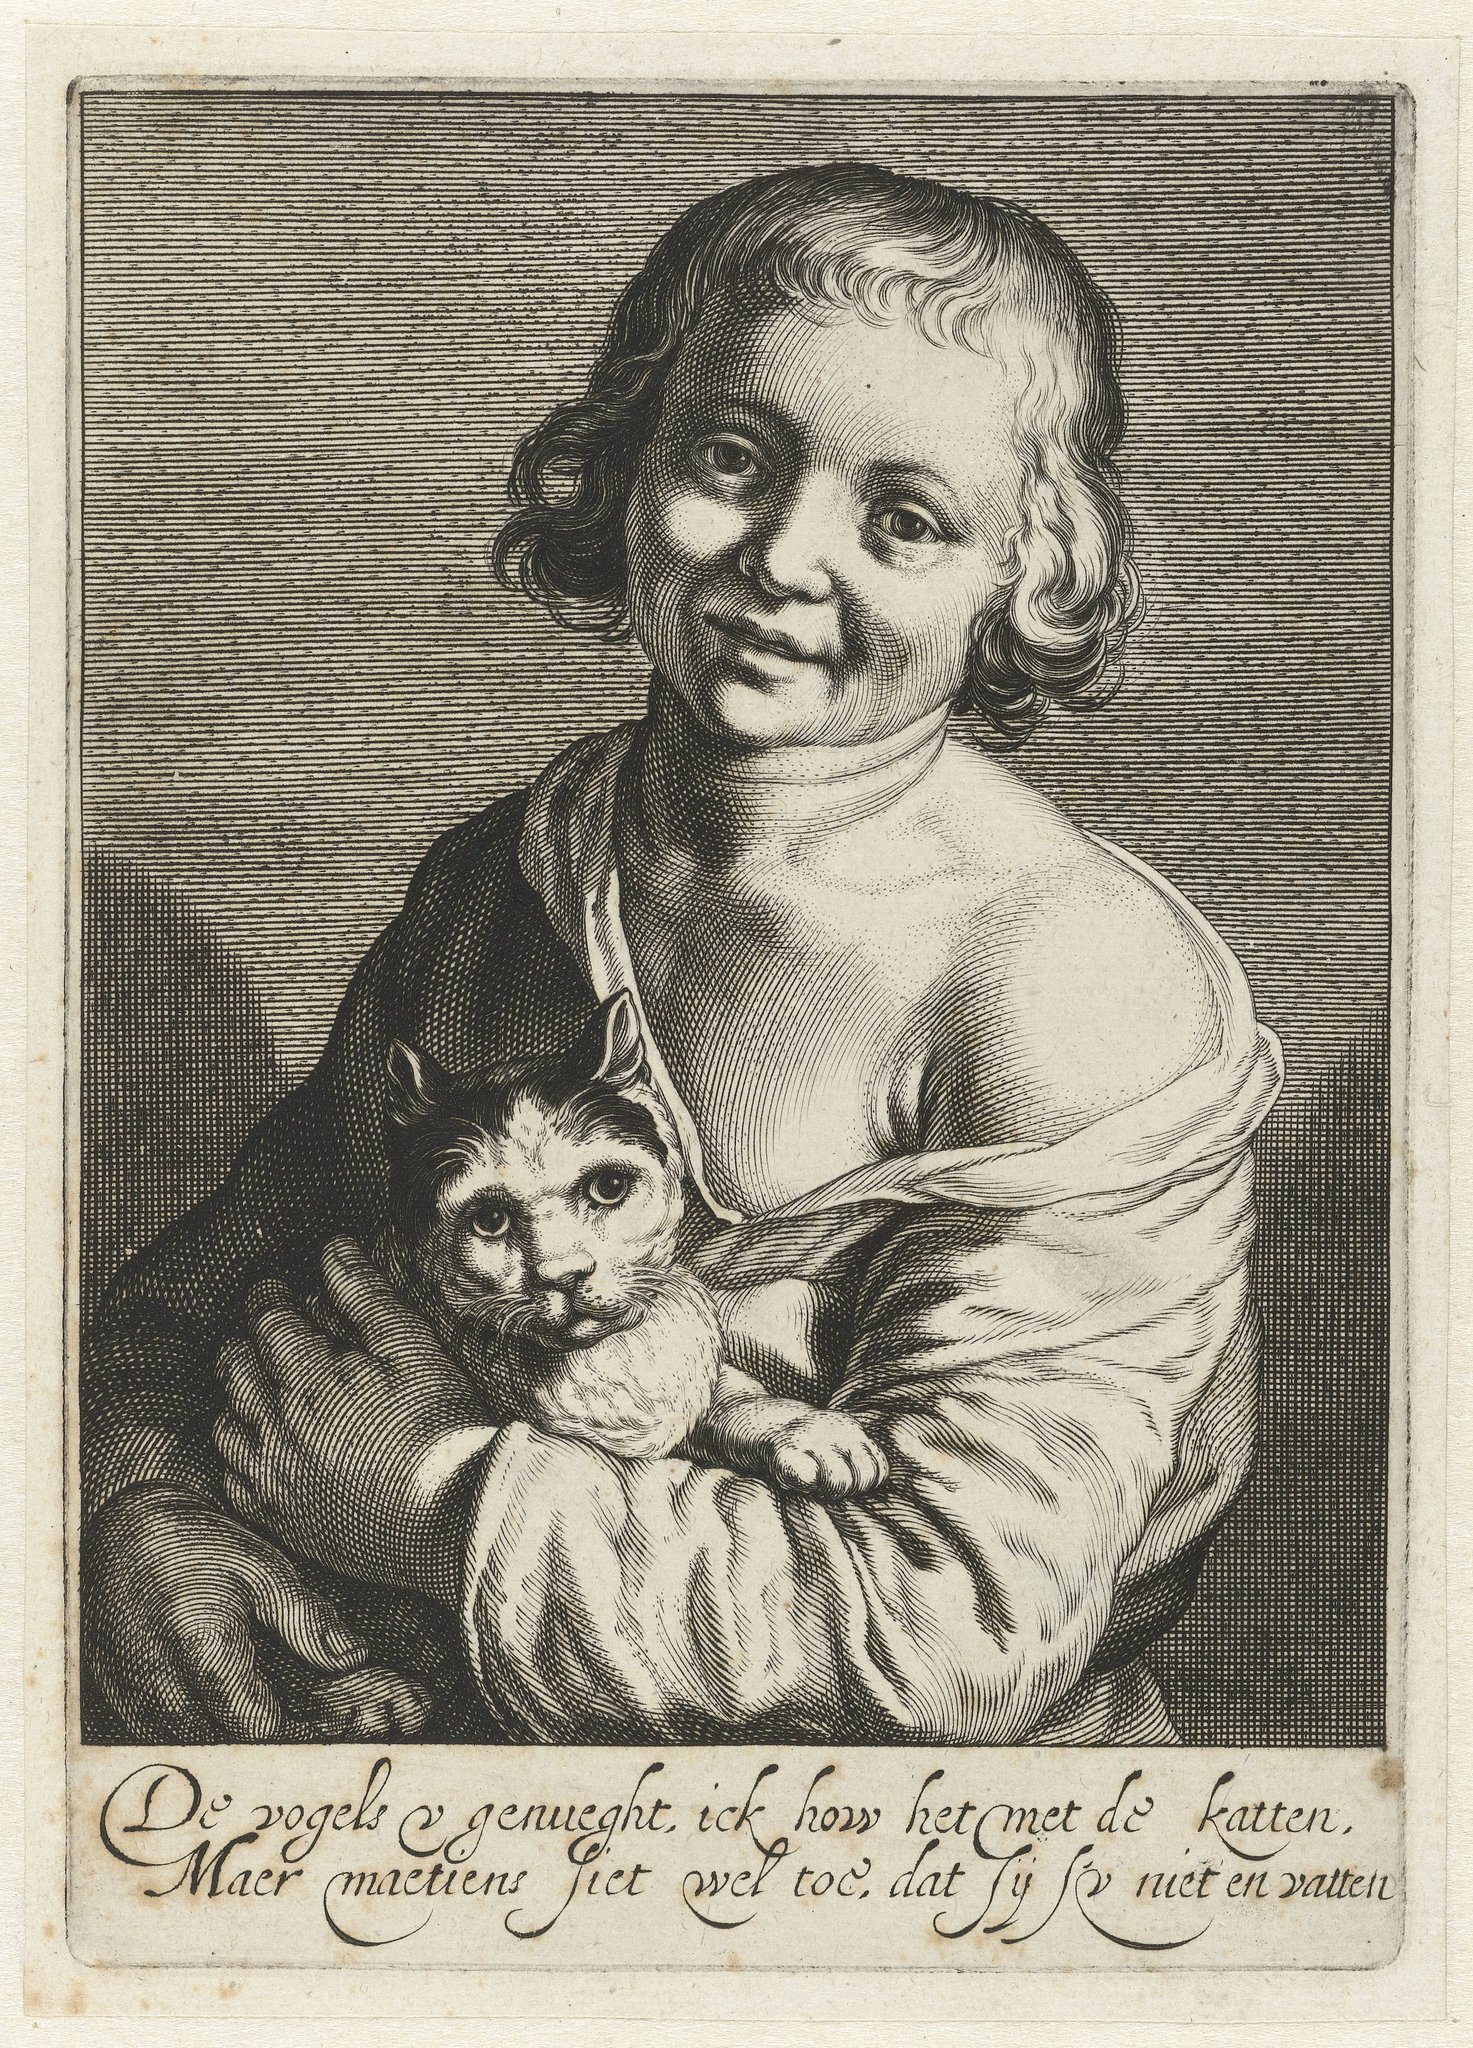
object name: print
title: Jongen met kat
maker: cornelis bloemaert (ii)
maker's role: draughtsman, print maker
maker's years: 1603-1692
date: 1625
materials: paper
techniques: engraving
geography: utrecht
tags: cat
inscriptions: collector's mark: Lugt 240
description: Een jongen houdt een kat in de armen, dicht tegen het lichaam aan. Met tweeregelig Nederlands onderschrift, waarin wordt gewaarschuwd tegen de roofzucht van de kat (of menselijk bedrog)